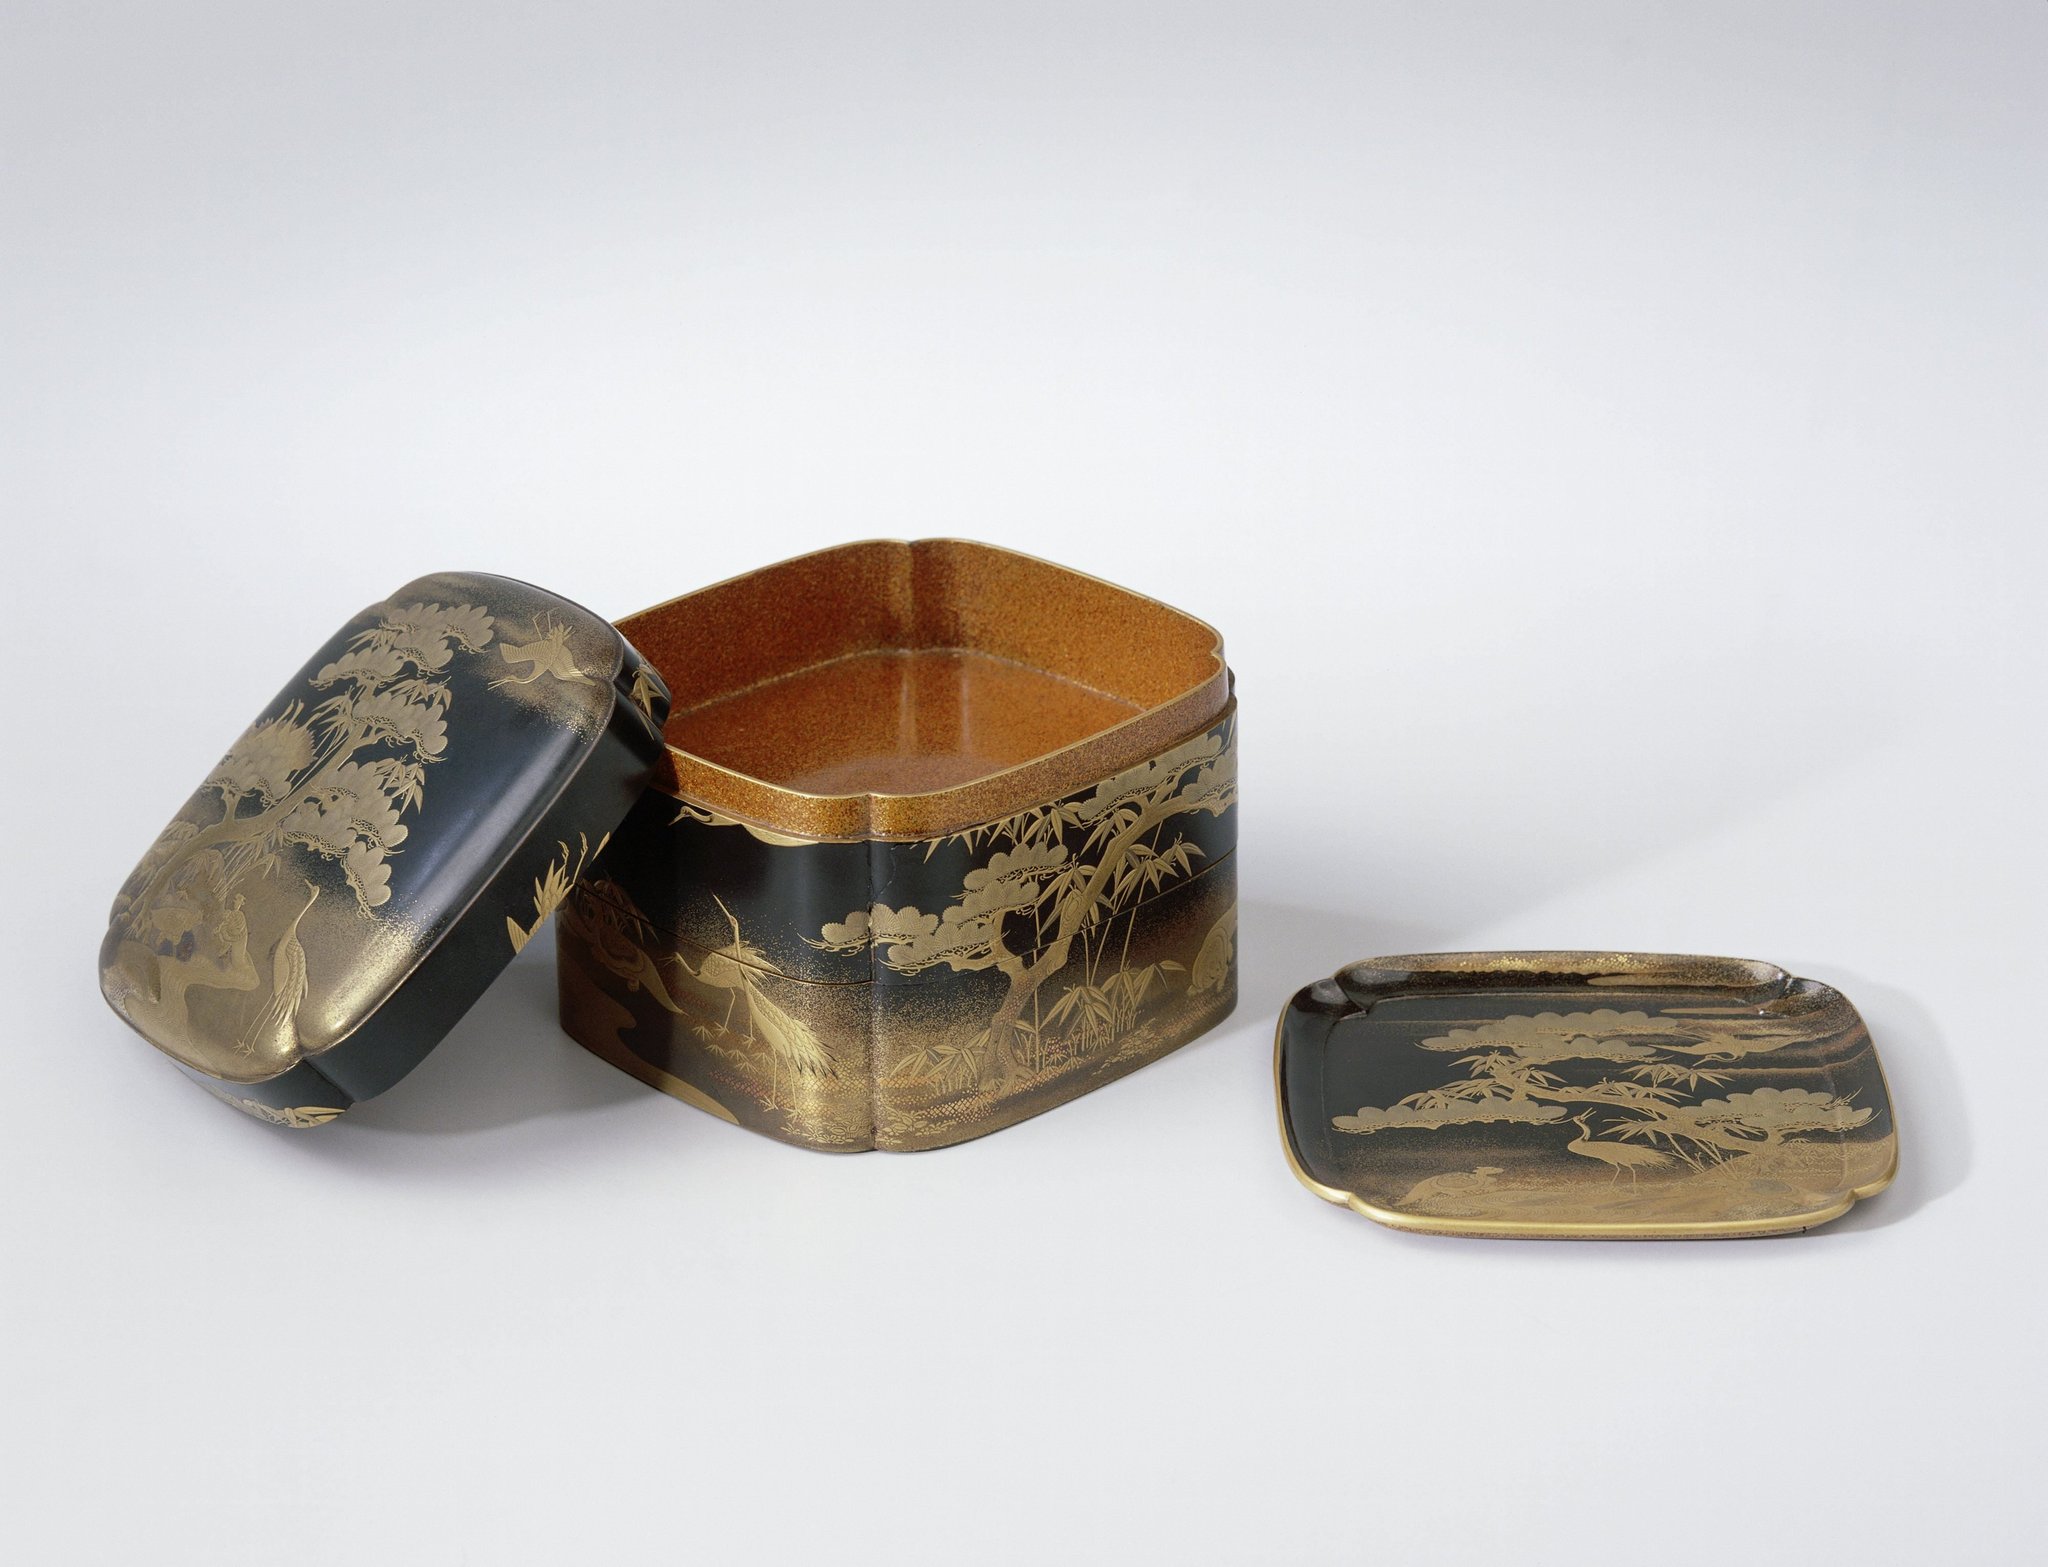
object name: box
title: Stapeldoos, zwarte lak en kraanvogels en schildpad in goud makie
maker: Anonymous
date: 1700-1800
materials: gold, lacquer, wood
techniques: lacquer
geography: japan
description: Hoge doos met ingenepen hoeken, bestaande uit twee opeensluitende bakjes en een enigszins bolle deksel. In de doos een passend blad. Van buiten bedekt met zwarte lak met bomen, bergen en kraanvogels in goud makie. Van binnen nashiji.